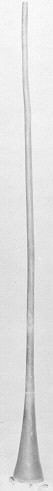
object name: metal tube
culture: belgian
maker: victor-charles mahillon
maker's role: maker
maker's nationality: belgian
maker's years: 1841-1924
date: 1867-1900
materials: metal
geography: belgium